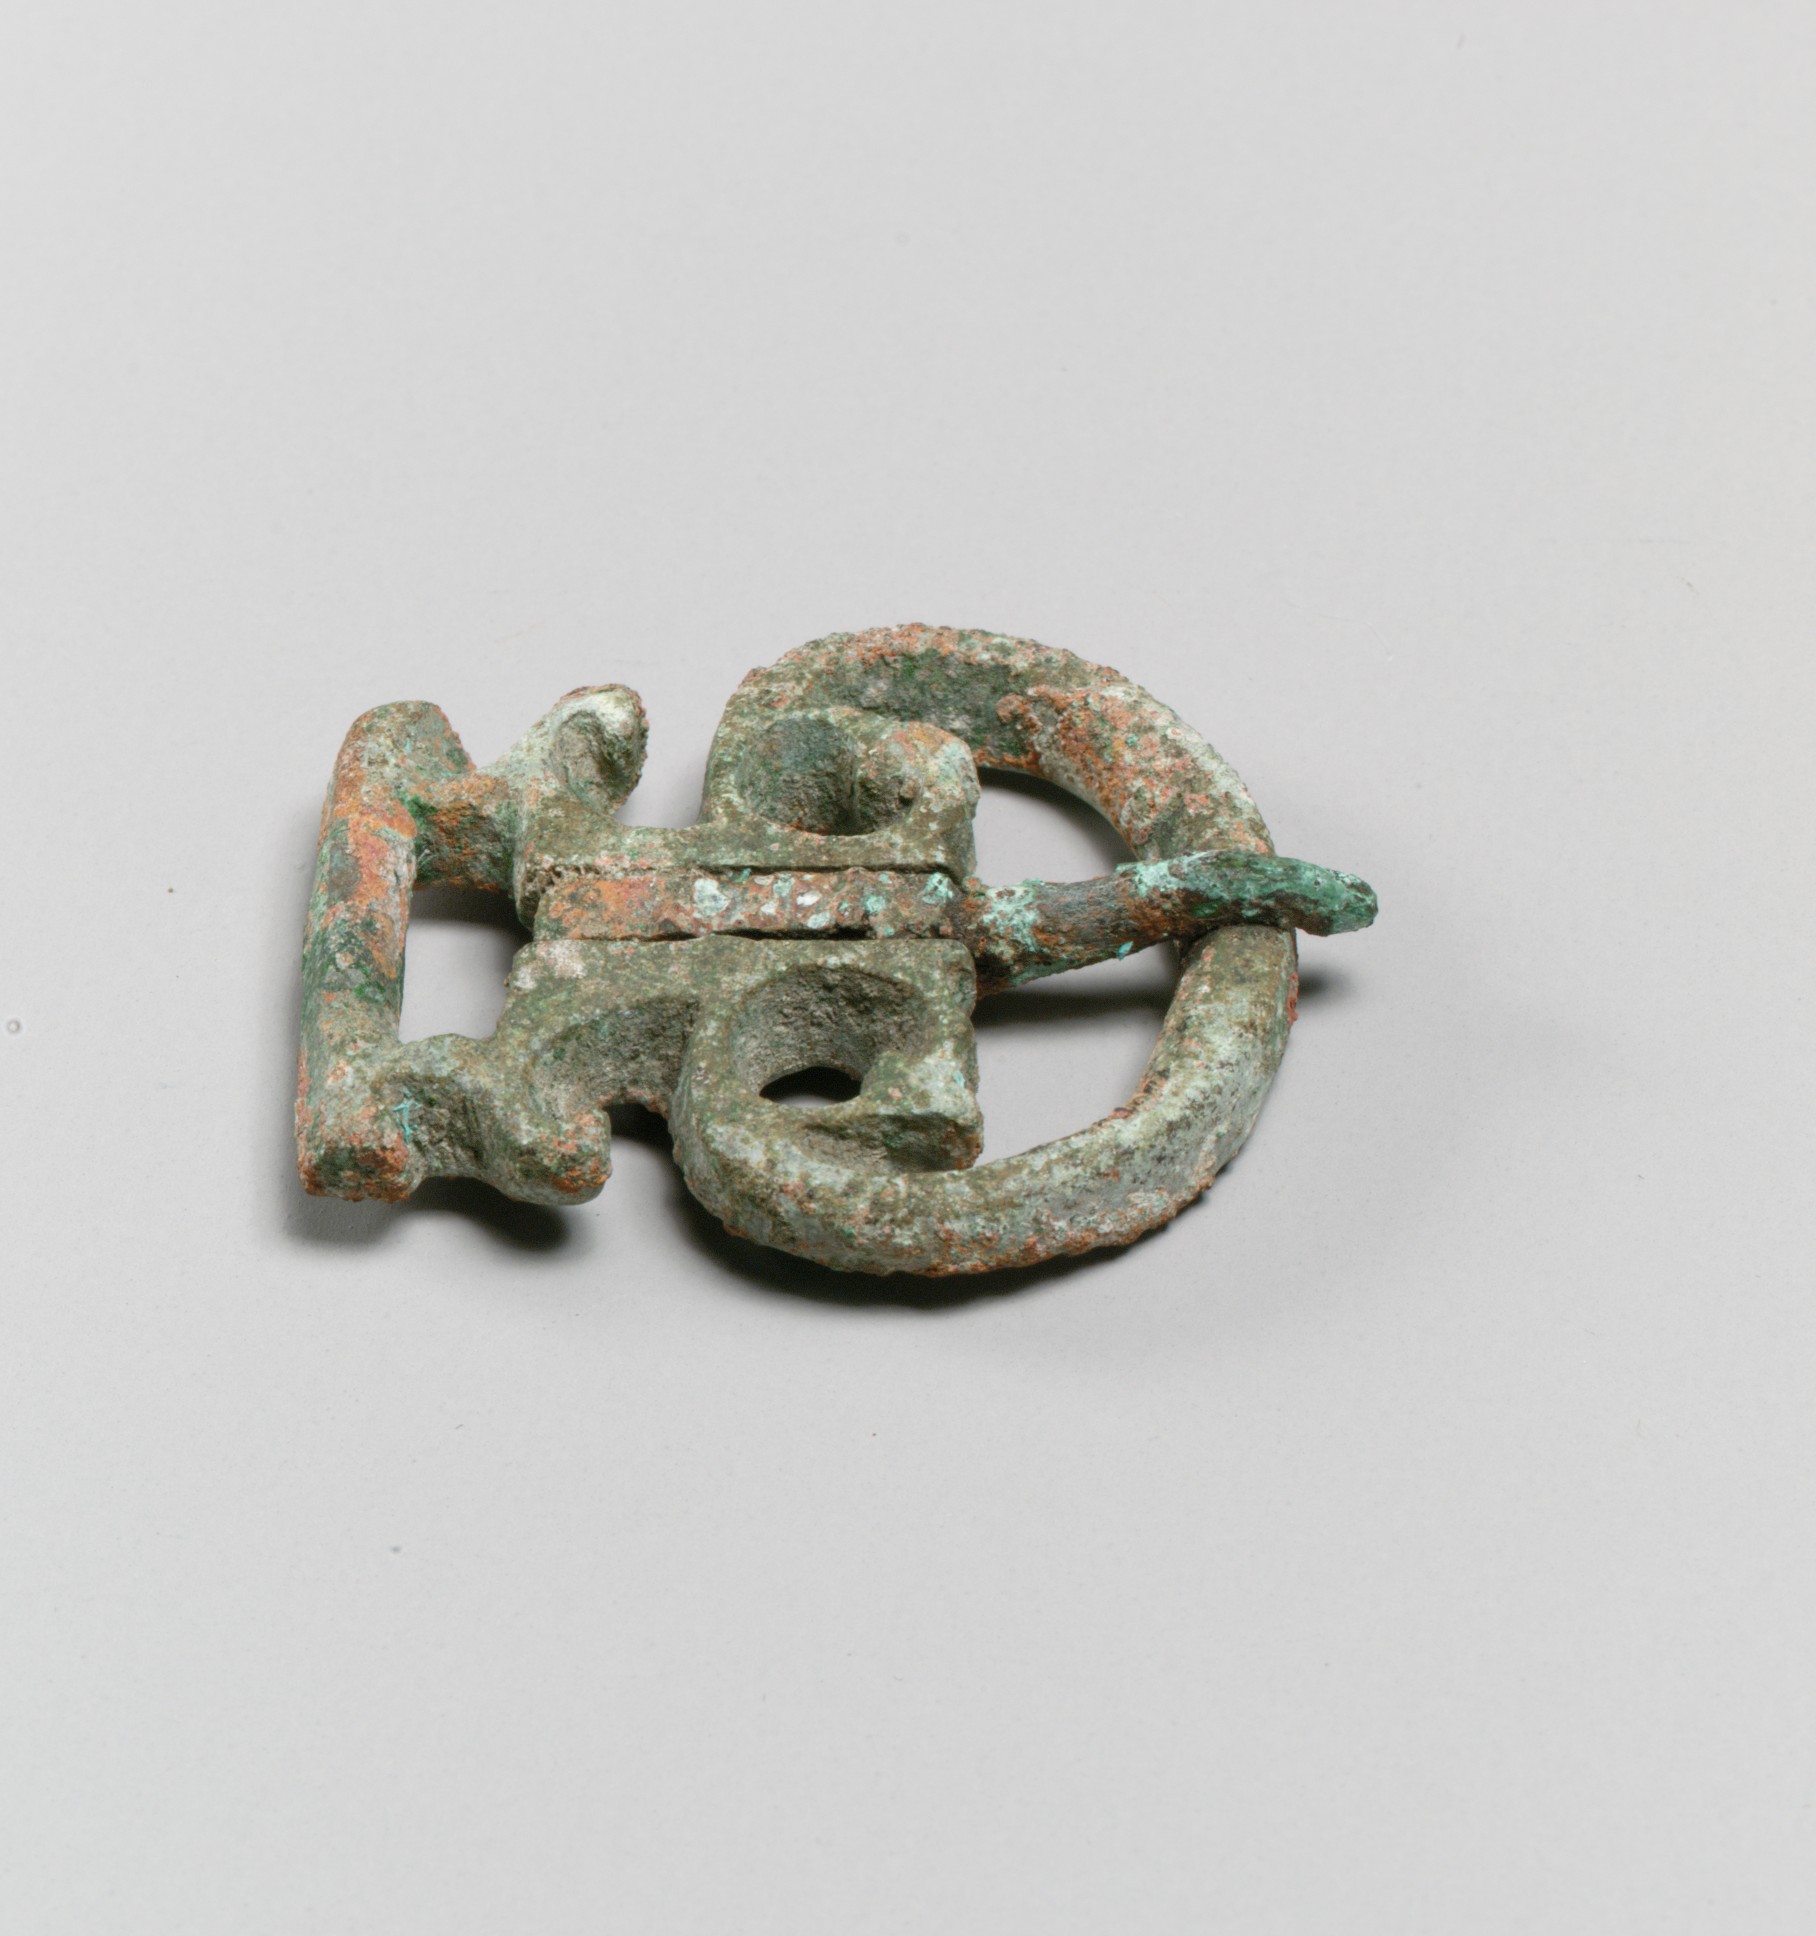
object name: buckle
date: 7000 BCE-330 CE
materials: bronze